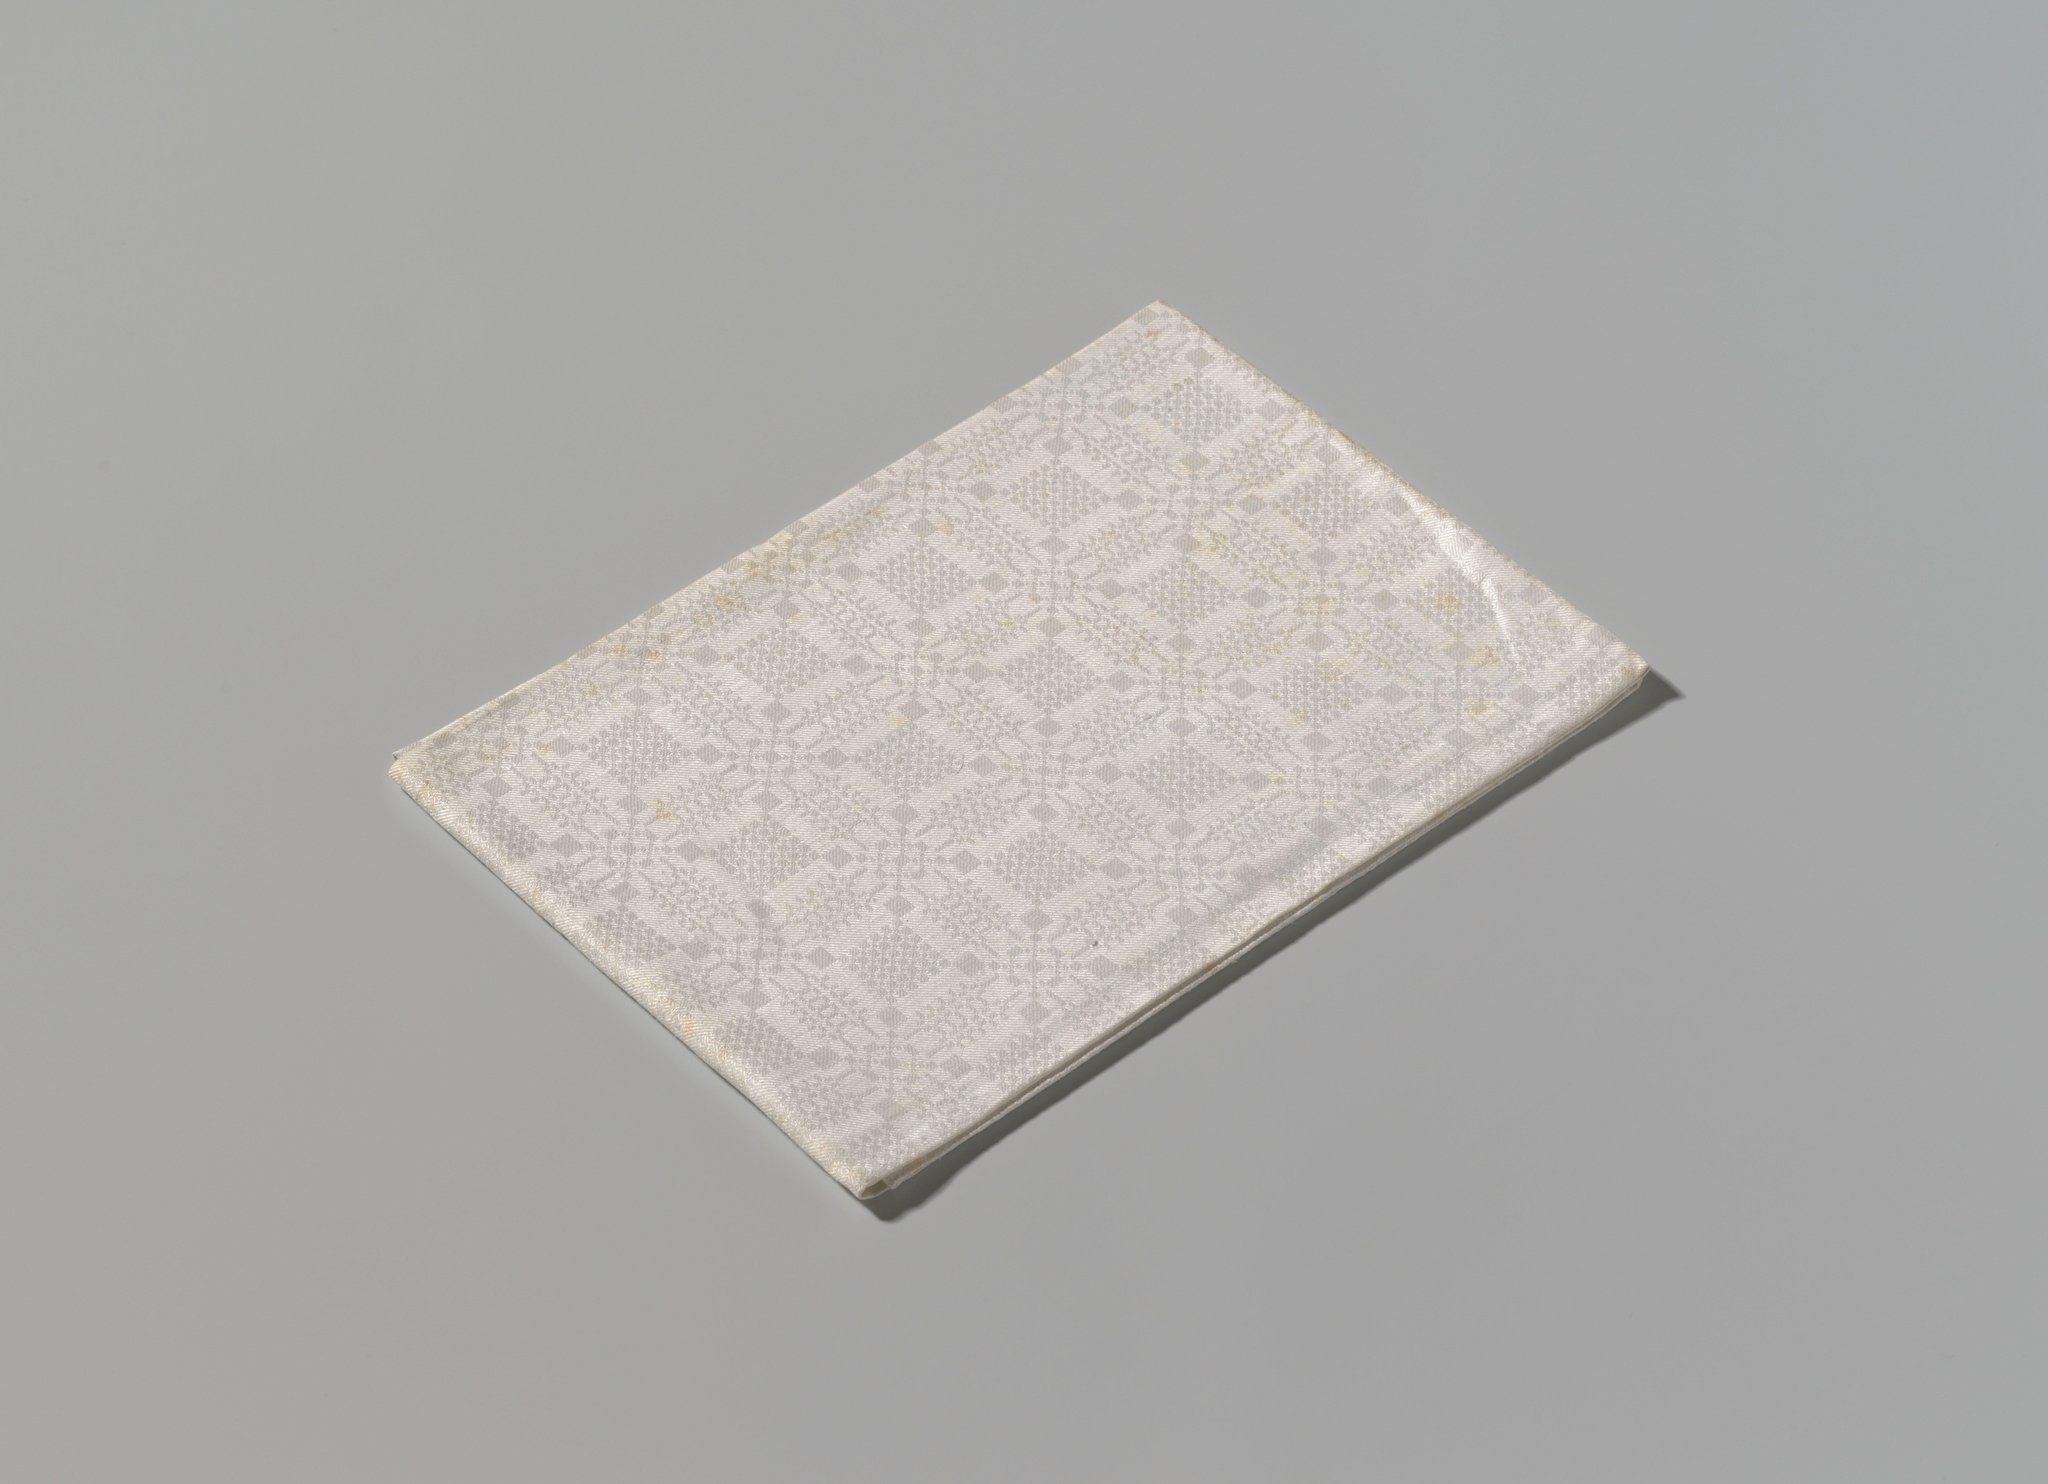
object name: handdwaal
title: Handdwaal van wit linnen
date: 1600-1699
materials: linen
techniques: twill, peeled fabric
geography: netherlands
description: Wit linnen handdwaal met een pellen patroon in keper, merk WR 6.